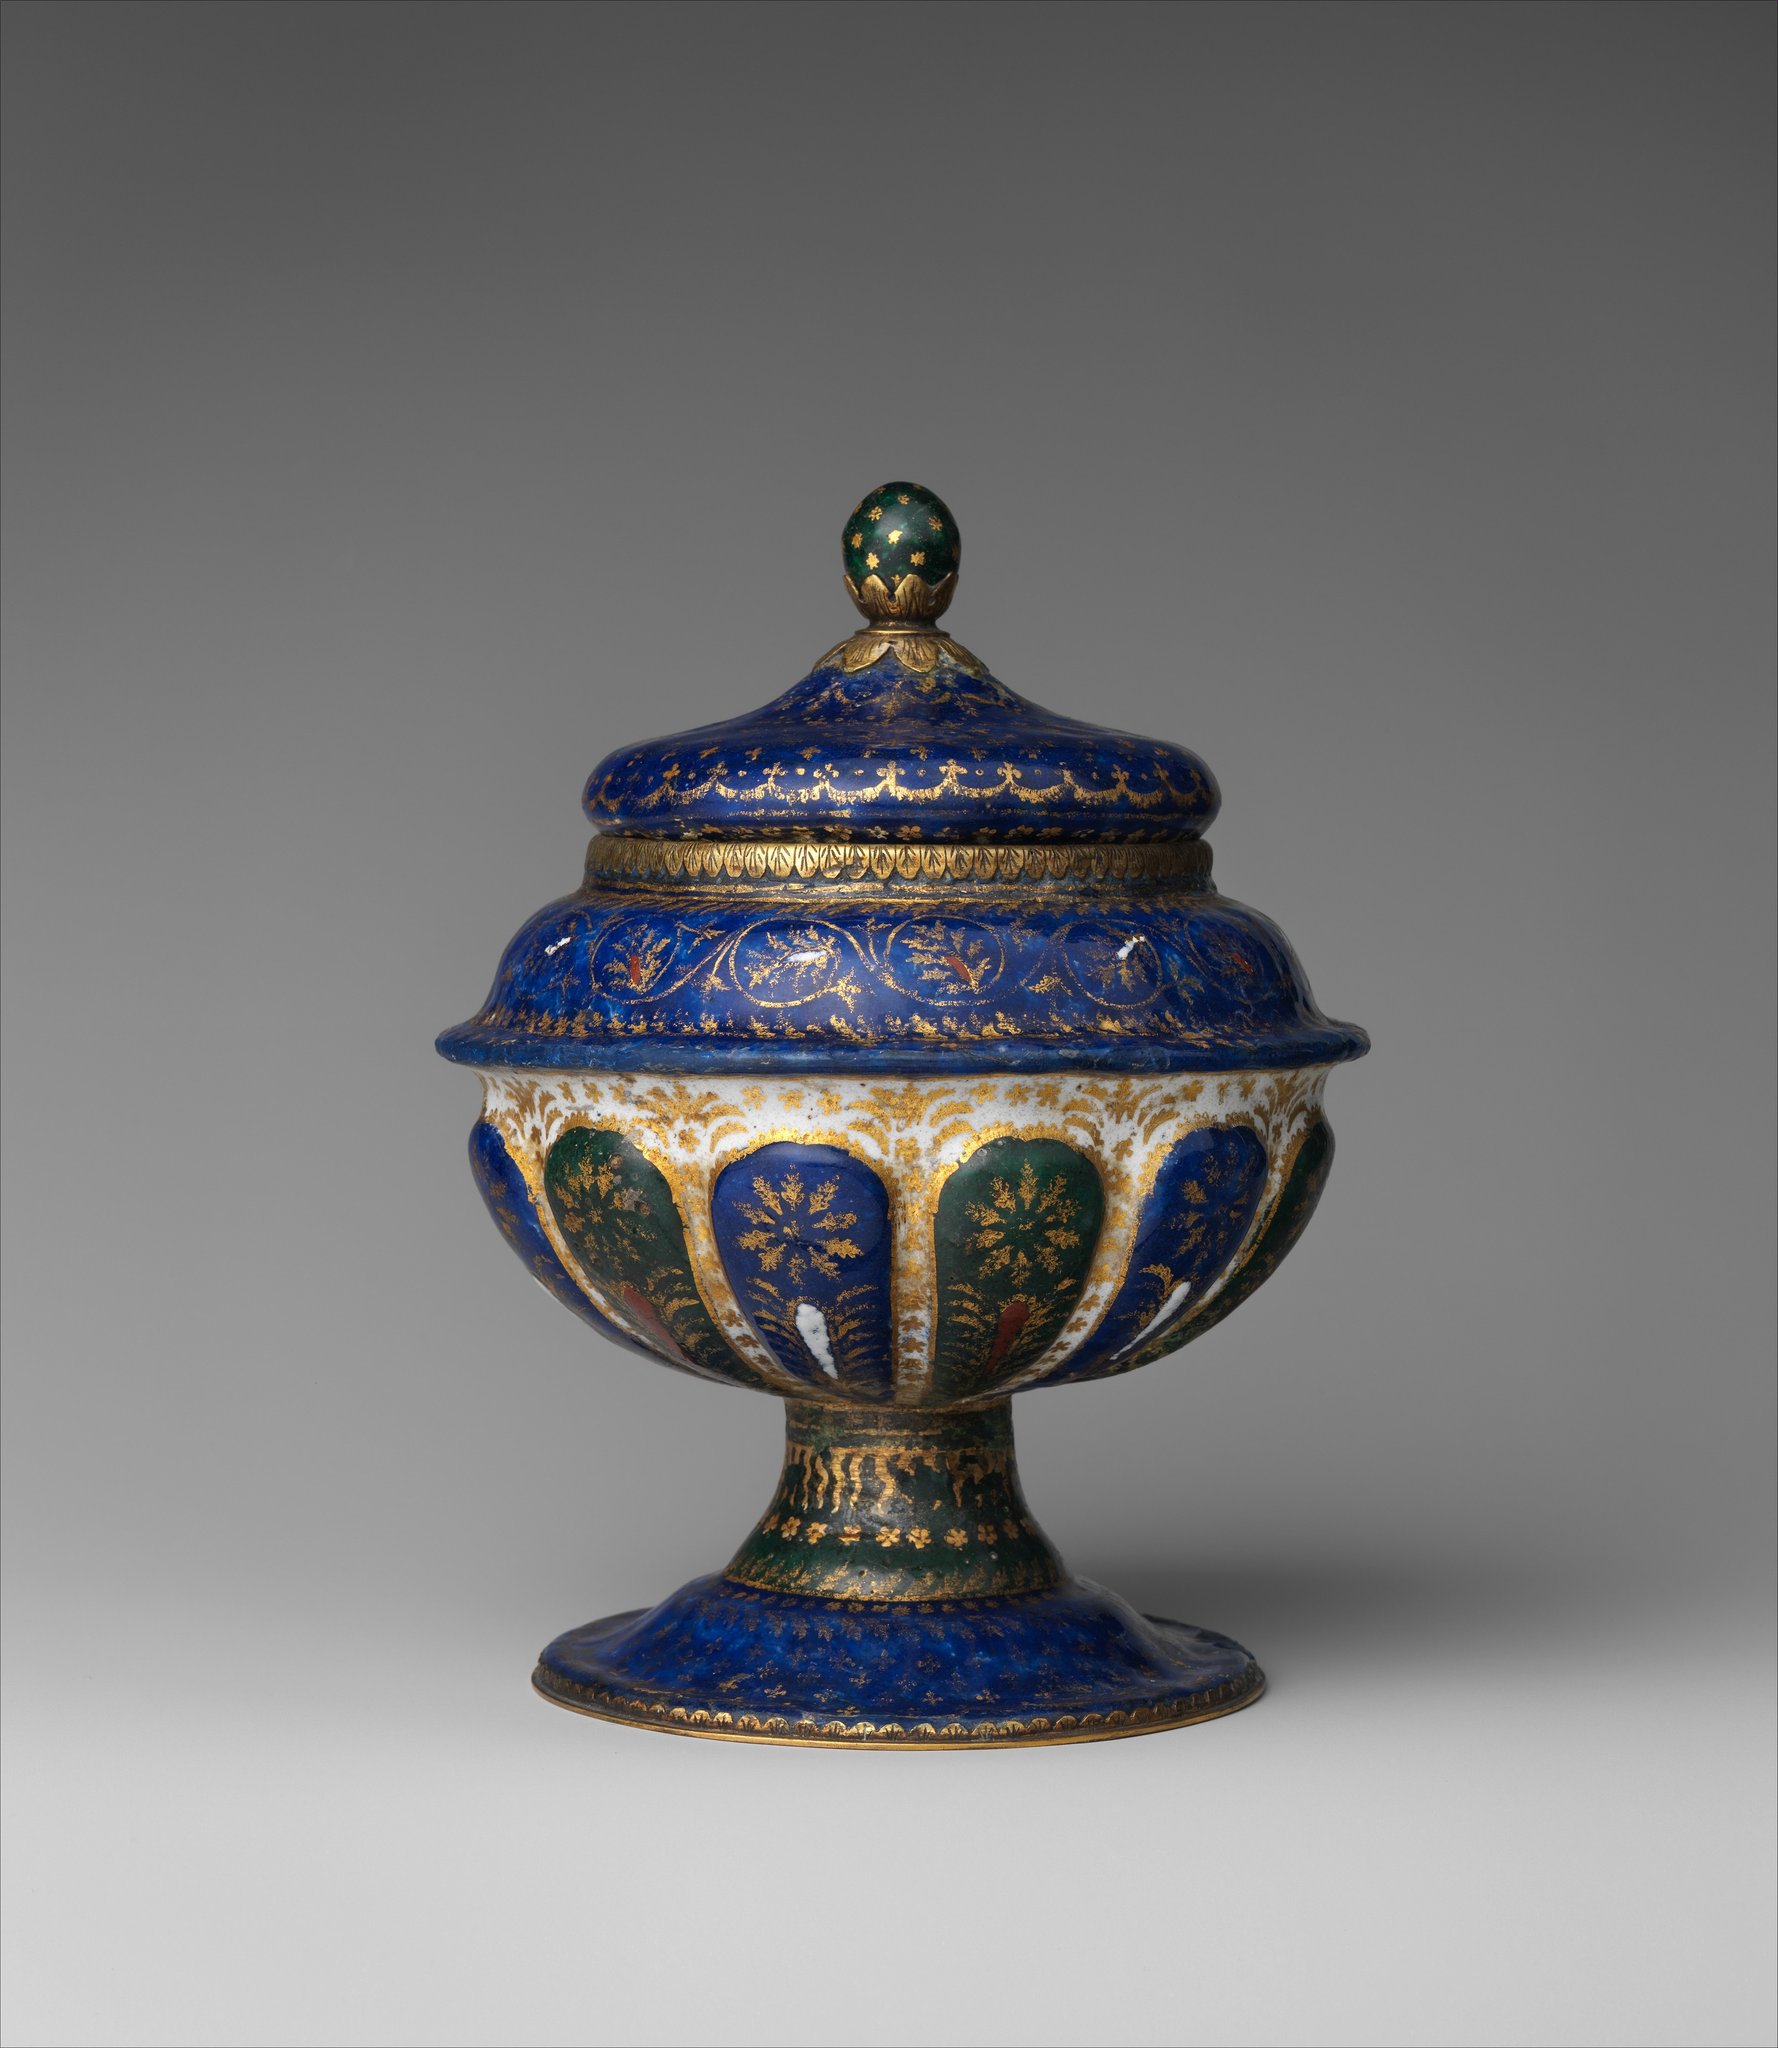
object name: cup with cover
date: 1467-1533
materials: copper, enamel, gilt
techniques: painting